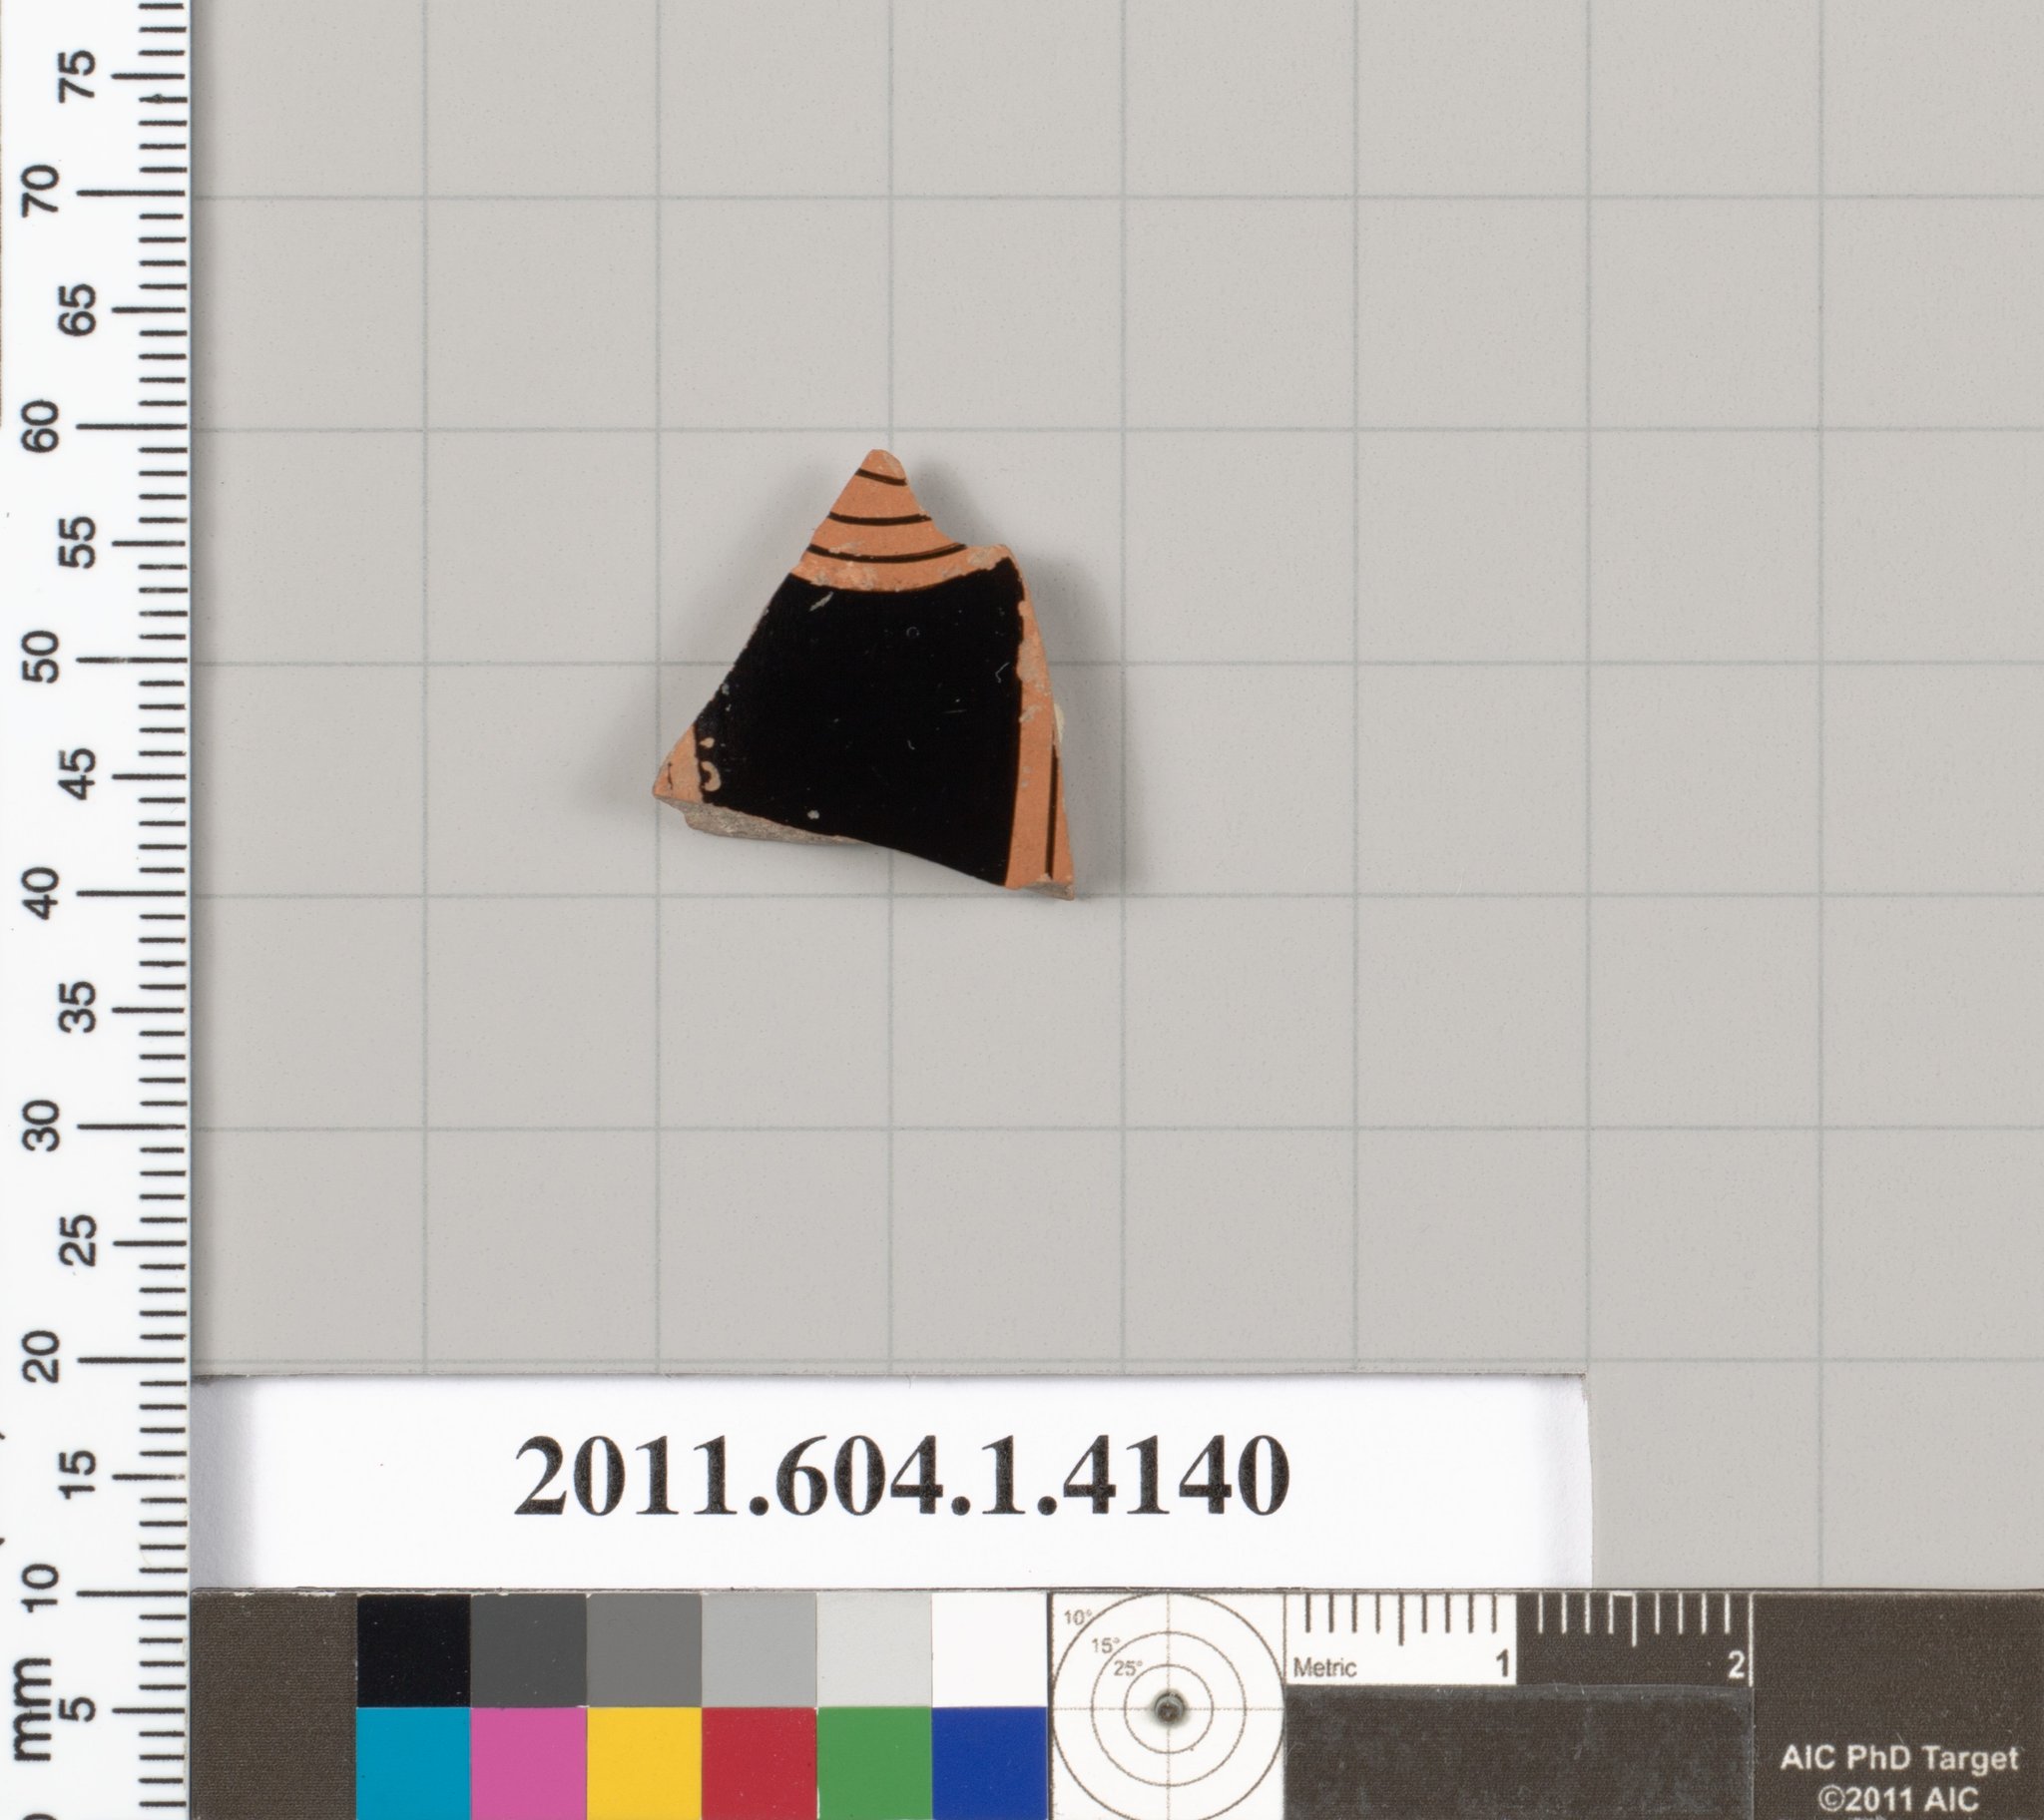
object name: kylix fragment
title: Terracotta fragment of a kylix (drinking cup)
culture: greek, attic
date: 490-470 BCE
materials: terracotta